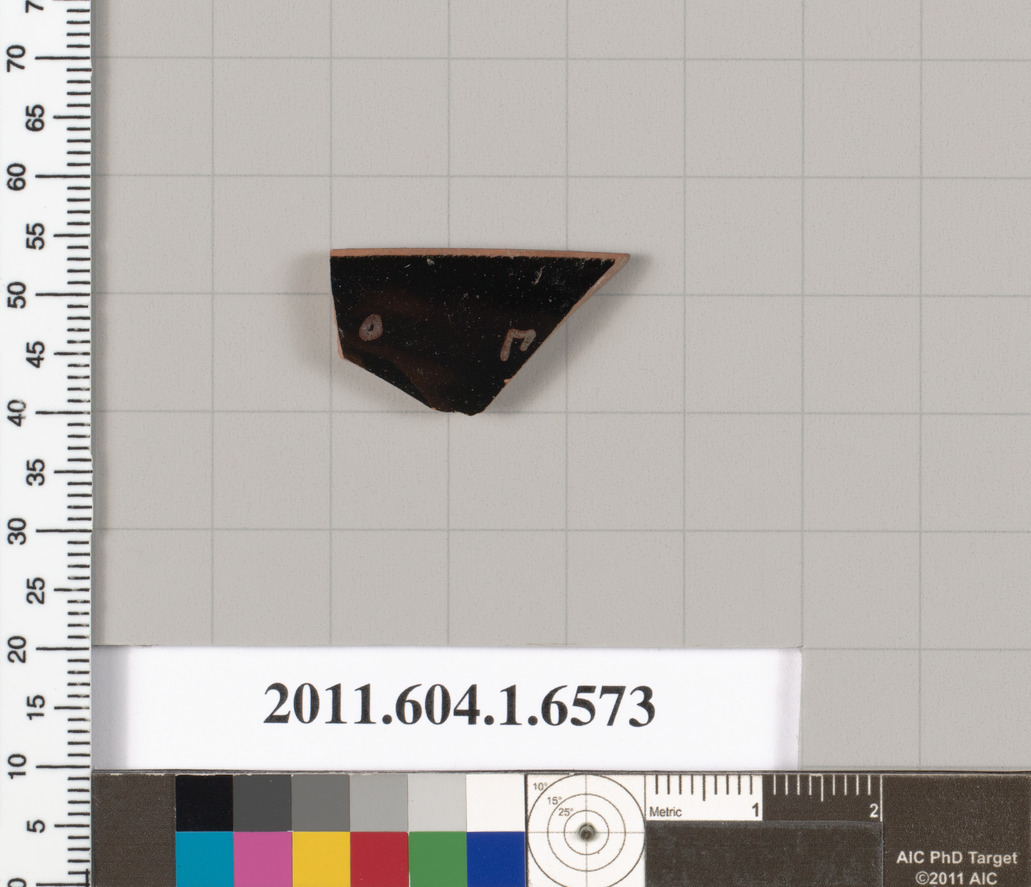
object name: kylix fragment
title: Terracotta rim fragment of a kylix (drinking cup)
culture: greek, attic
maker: colmar painter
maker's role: artist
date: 490-480 BCE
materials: terracotta